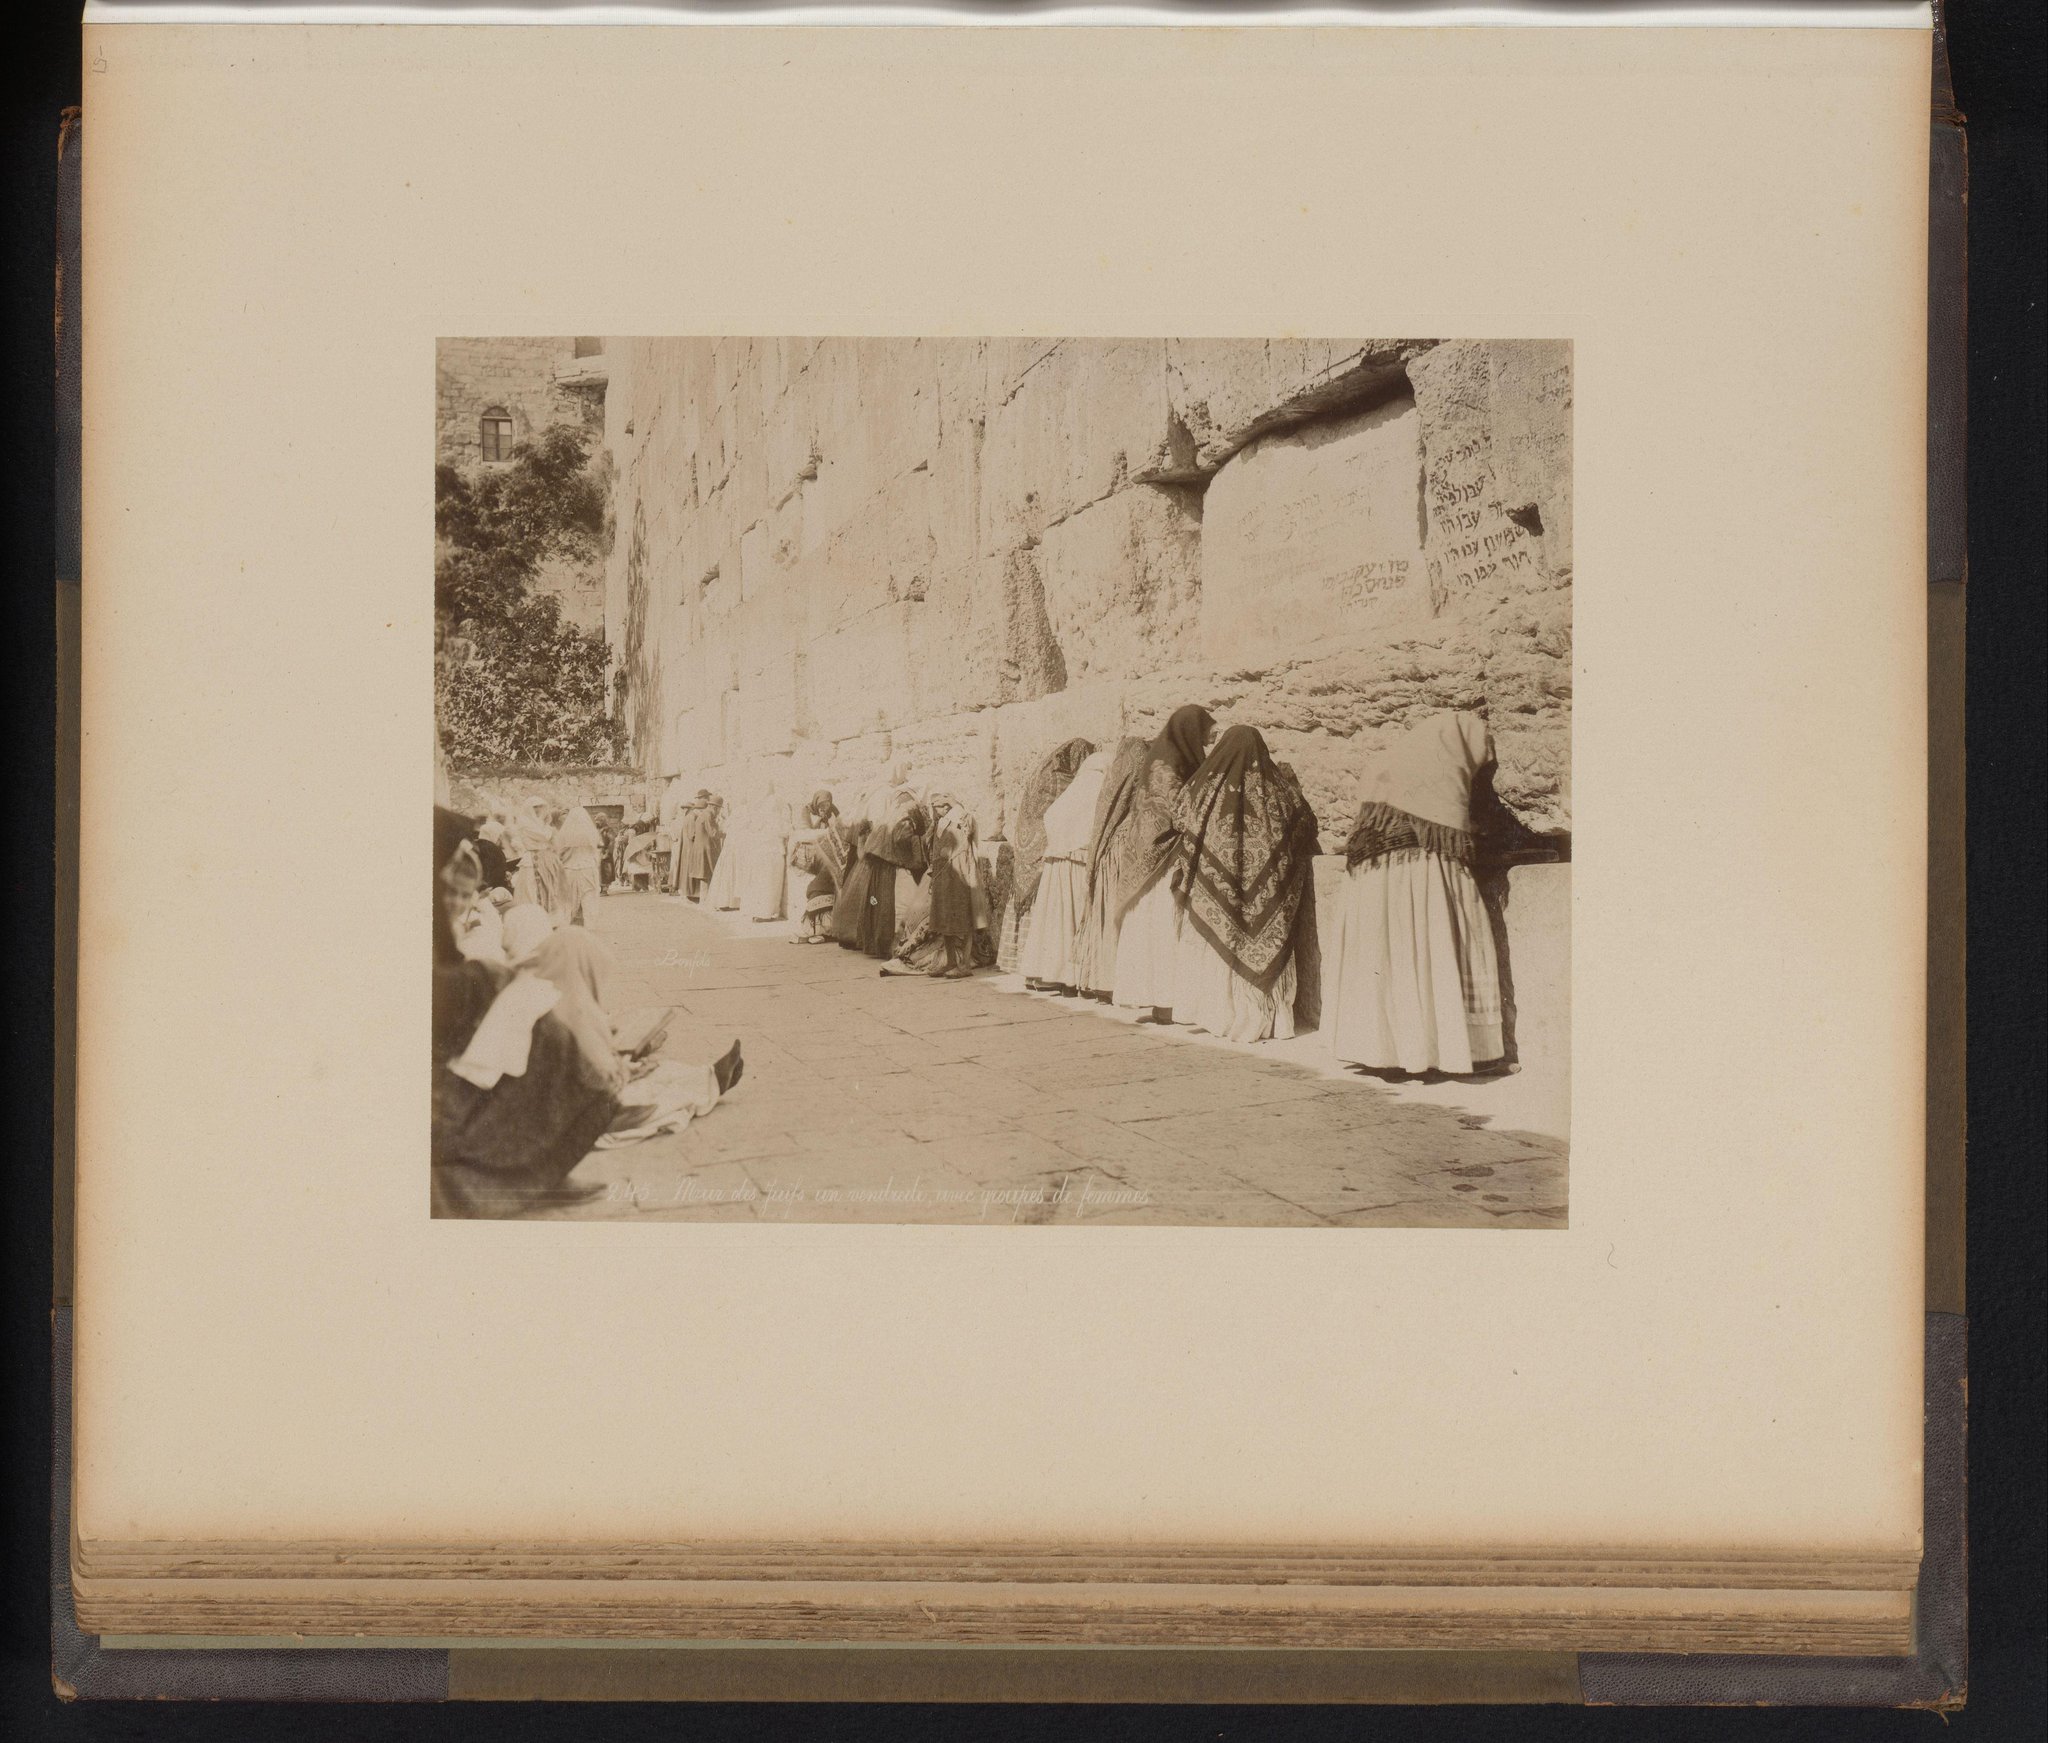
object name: photograph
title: Mur des Juifs un vendredi, avec groupes de femmes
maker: félix bonfils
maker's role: fotograaf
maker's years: 1831-1885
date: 1867-1885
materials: paper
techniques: albumen print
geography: jerusalem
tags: walls ~ fortified city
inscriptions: number: ‘245’